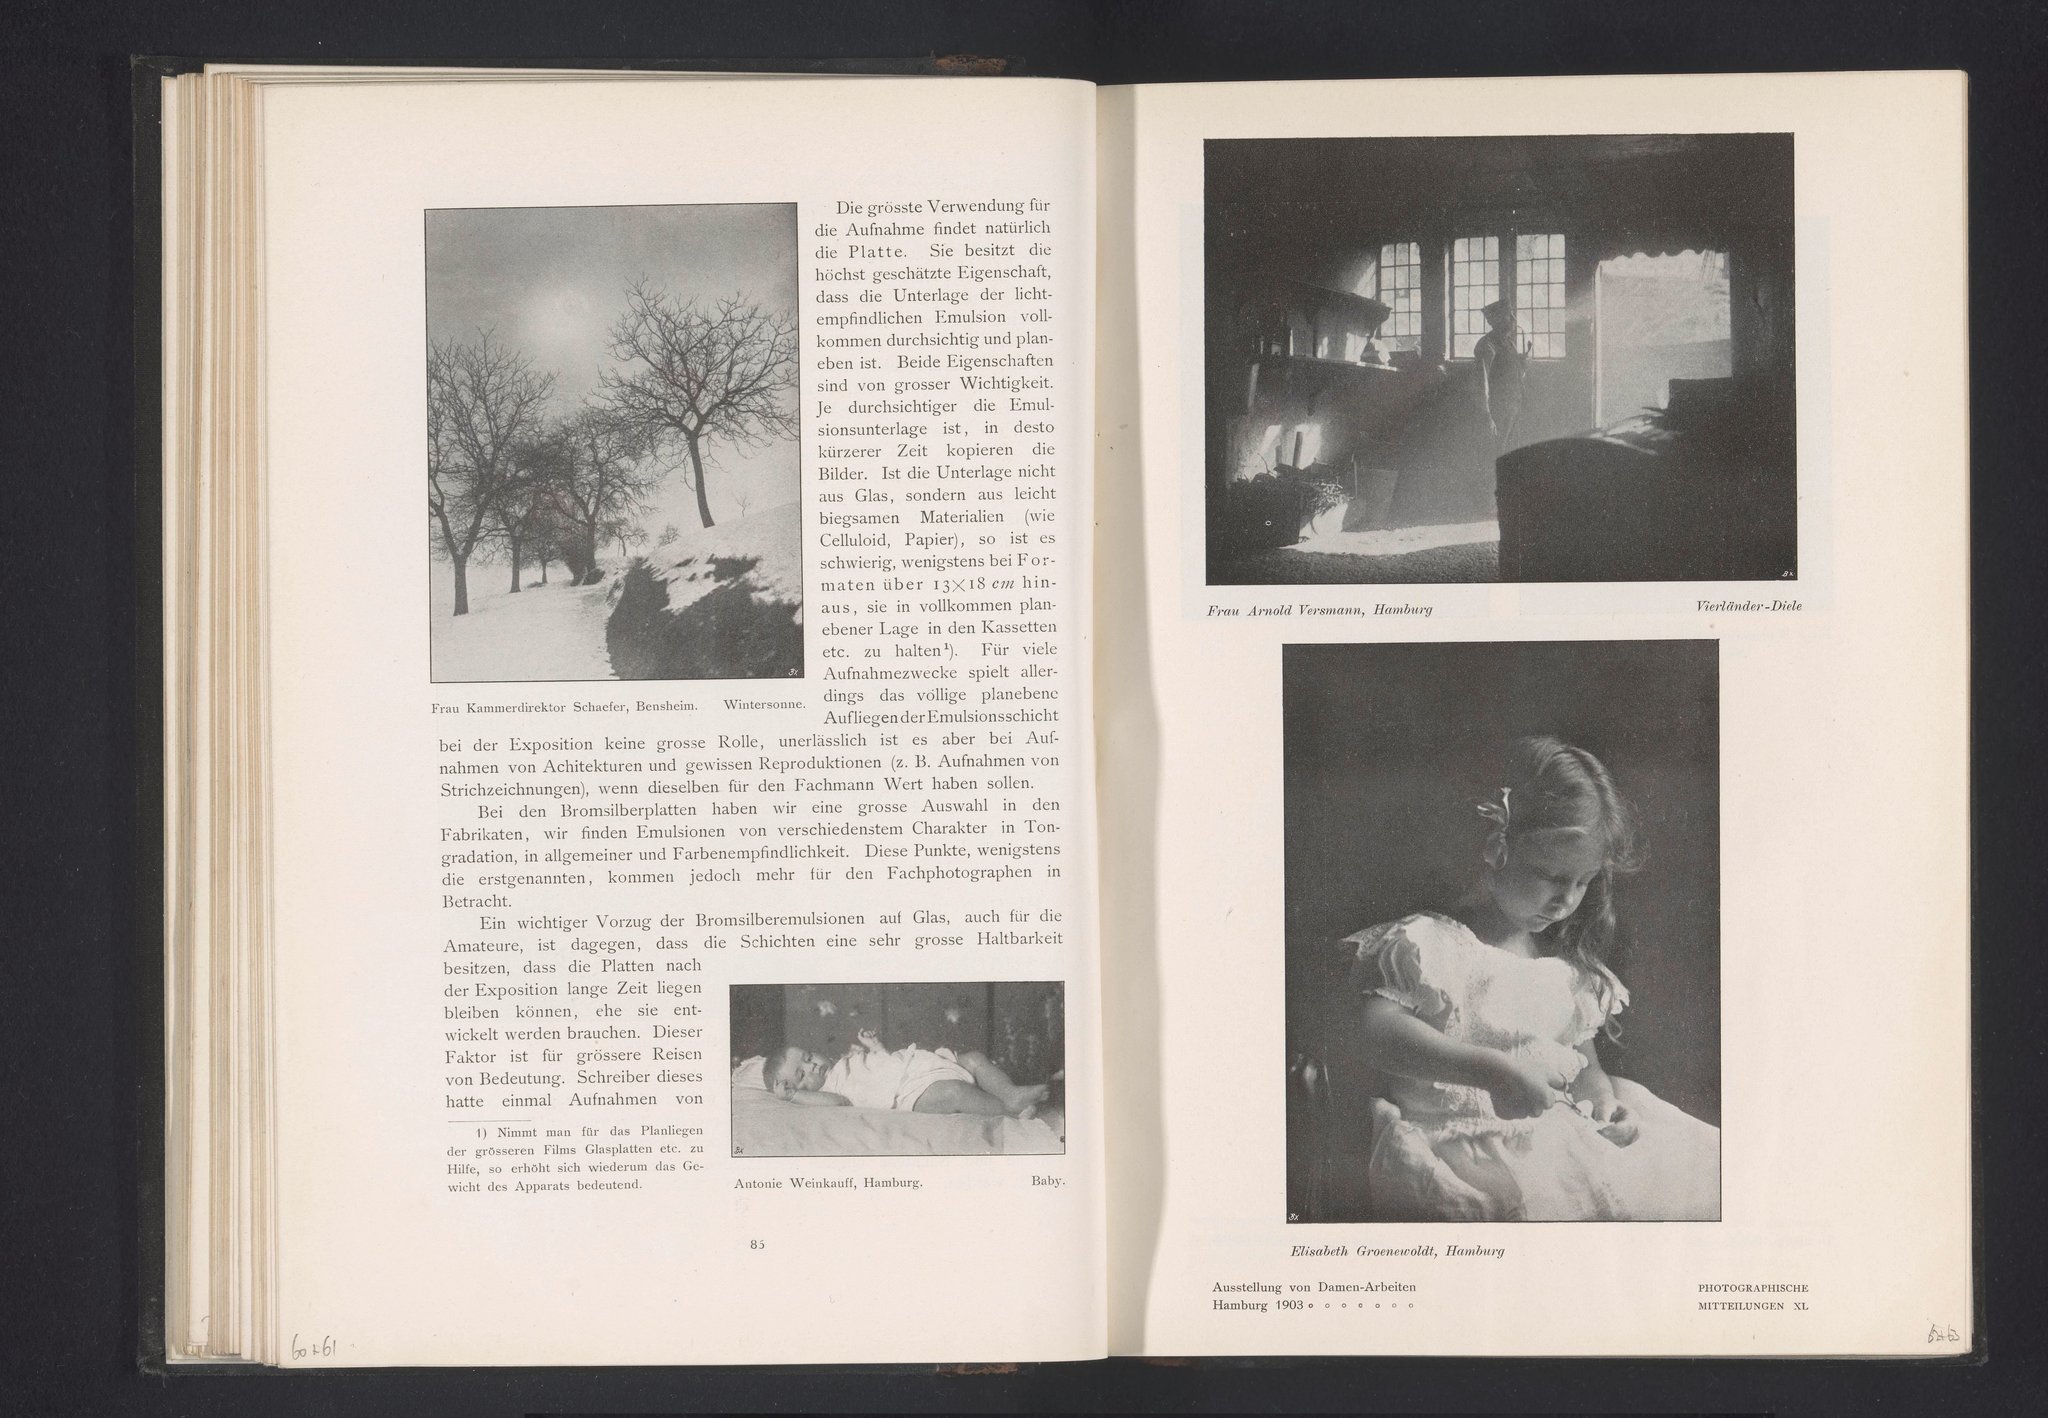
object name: page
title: Portret van een onbekend meisje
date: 1898-1903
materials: paper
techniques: autotype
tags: historical persons - bb - woman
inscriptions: inscription: ‘Frau Arnold Versmann, hamburg’, monogram: ‘BX’, inscription: ‘Ausstellung von Damen-Arbeiten Hamburg 1903’, inscription: ‘Photographische Mitteilungen XL’